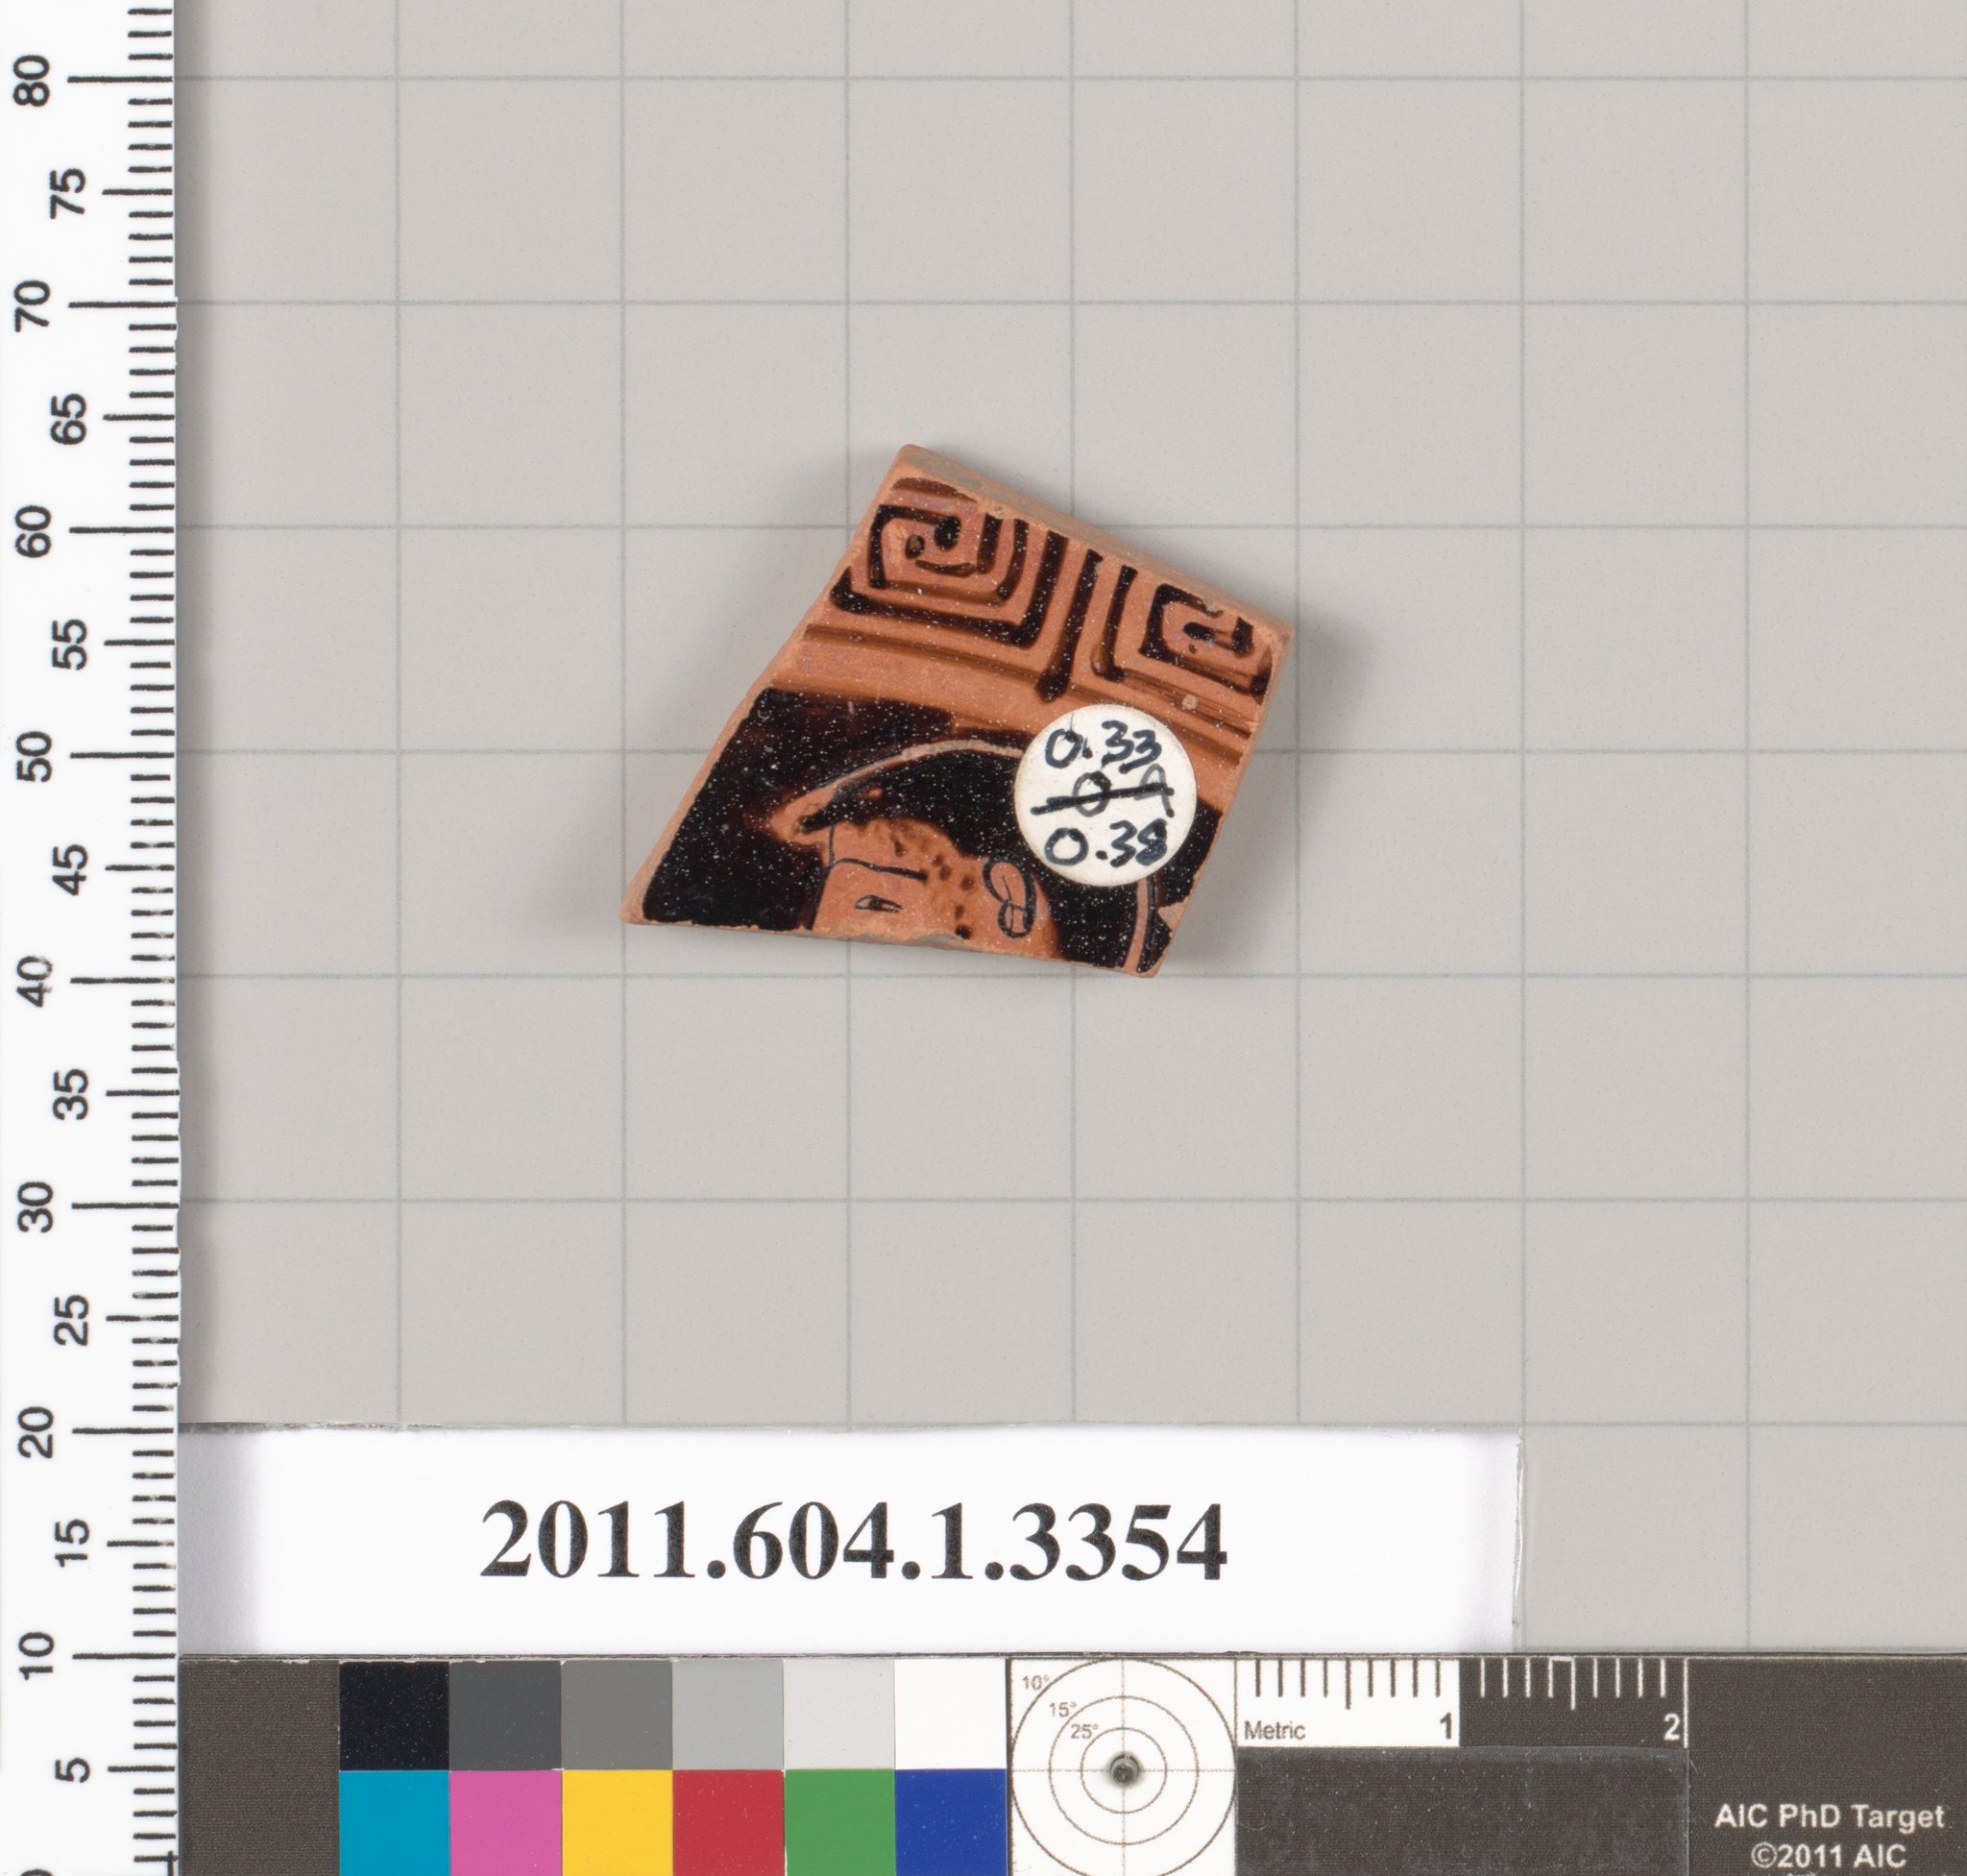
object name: kylix fragment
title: Terracotta fragment of a kylix (drinking cup)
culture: greek, attic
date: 480-470 BCE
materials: terracotta